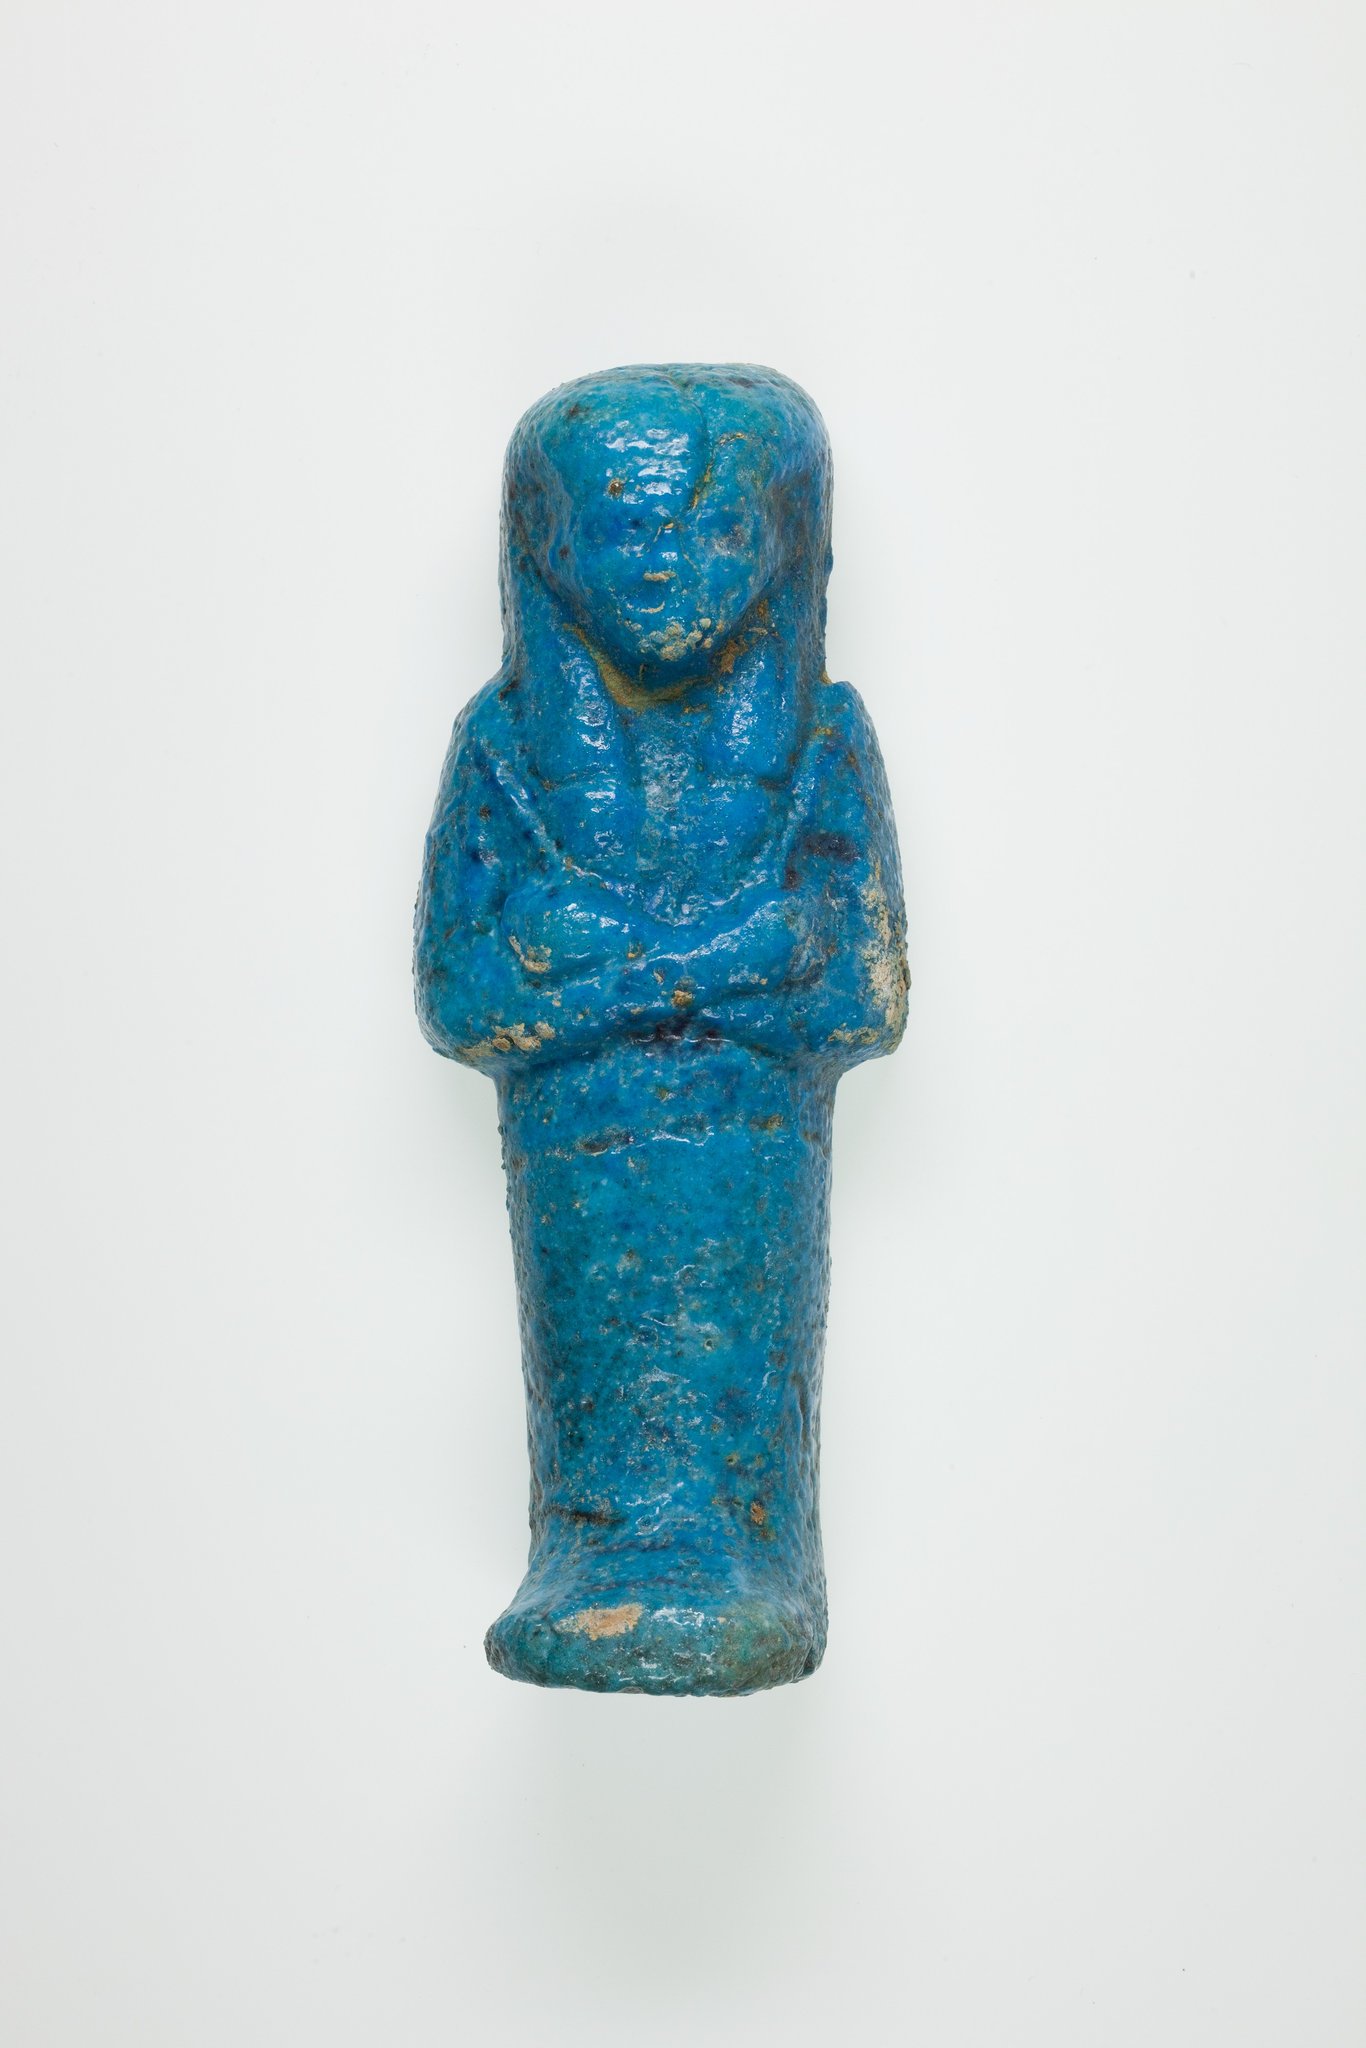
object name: shabti, henettawy c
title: Worker Shabti of Henettawy (C), Daughter of Isetemkheb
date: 990-970 BCE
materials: faience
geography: egypt